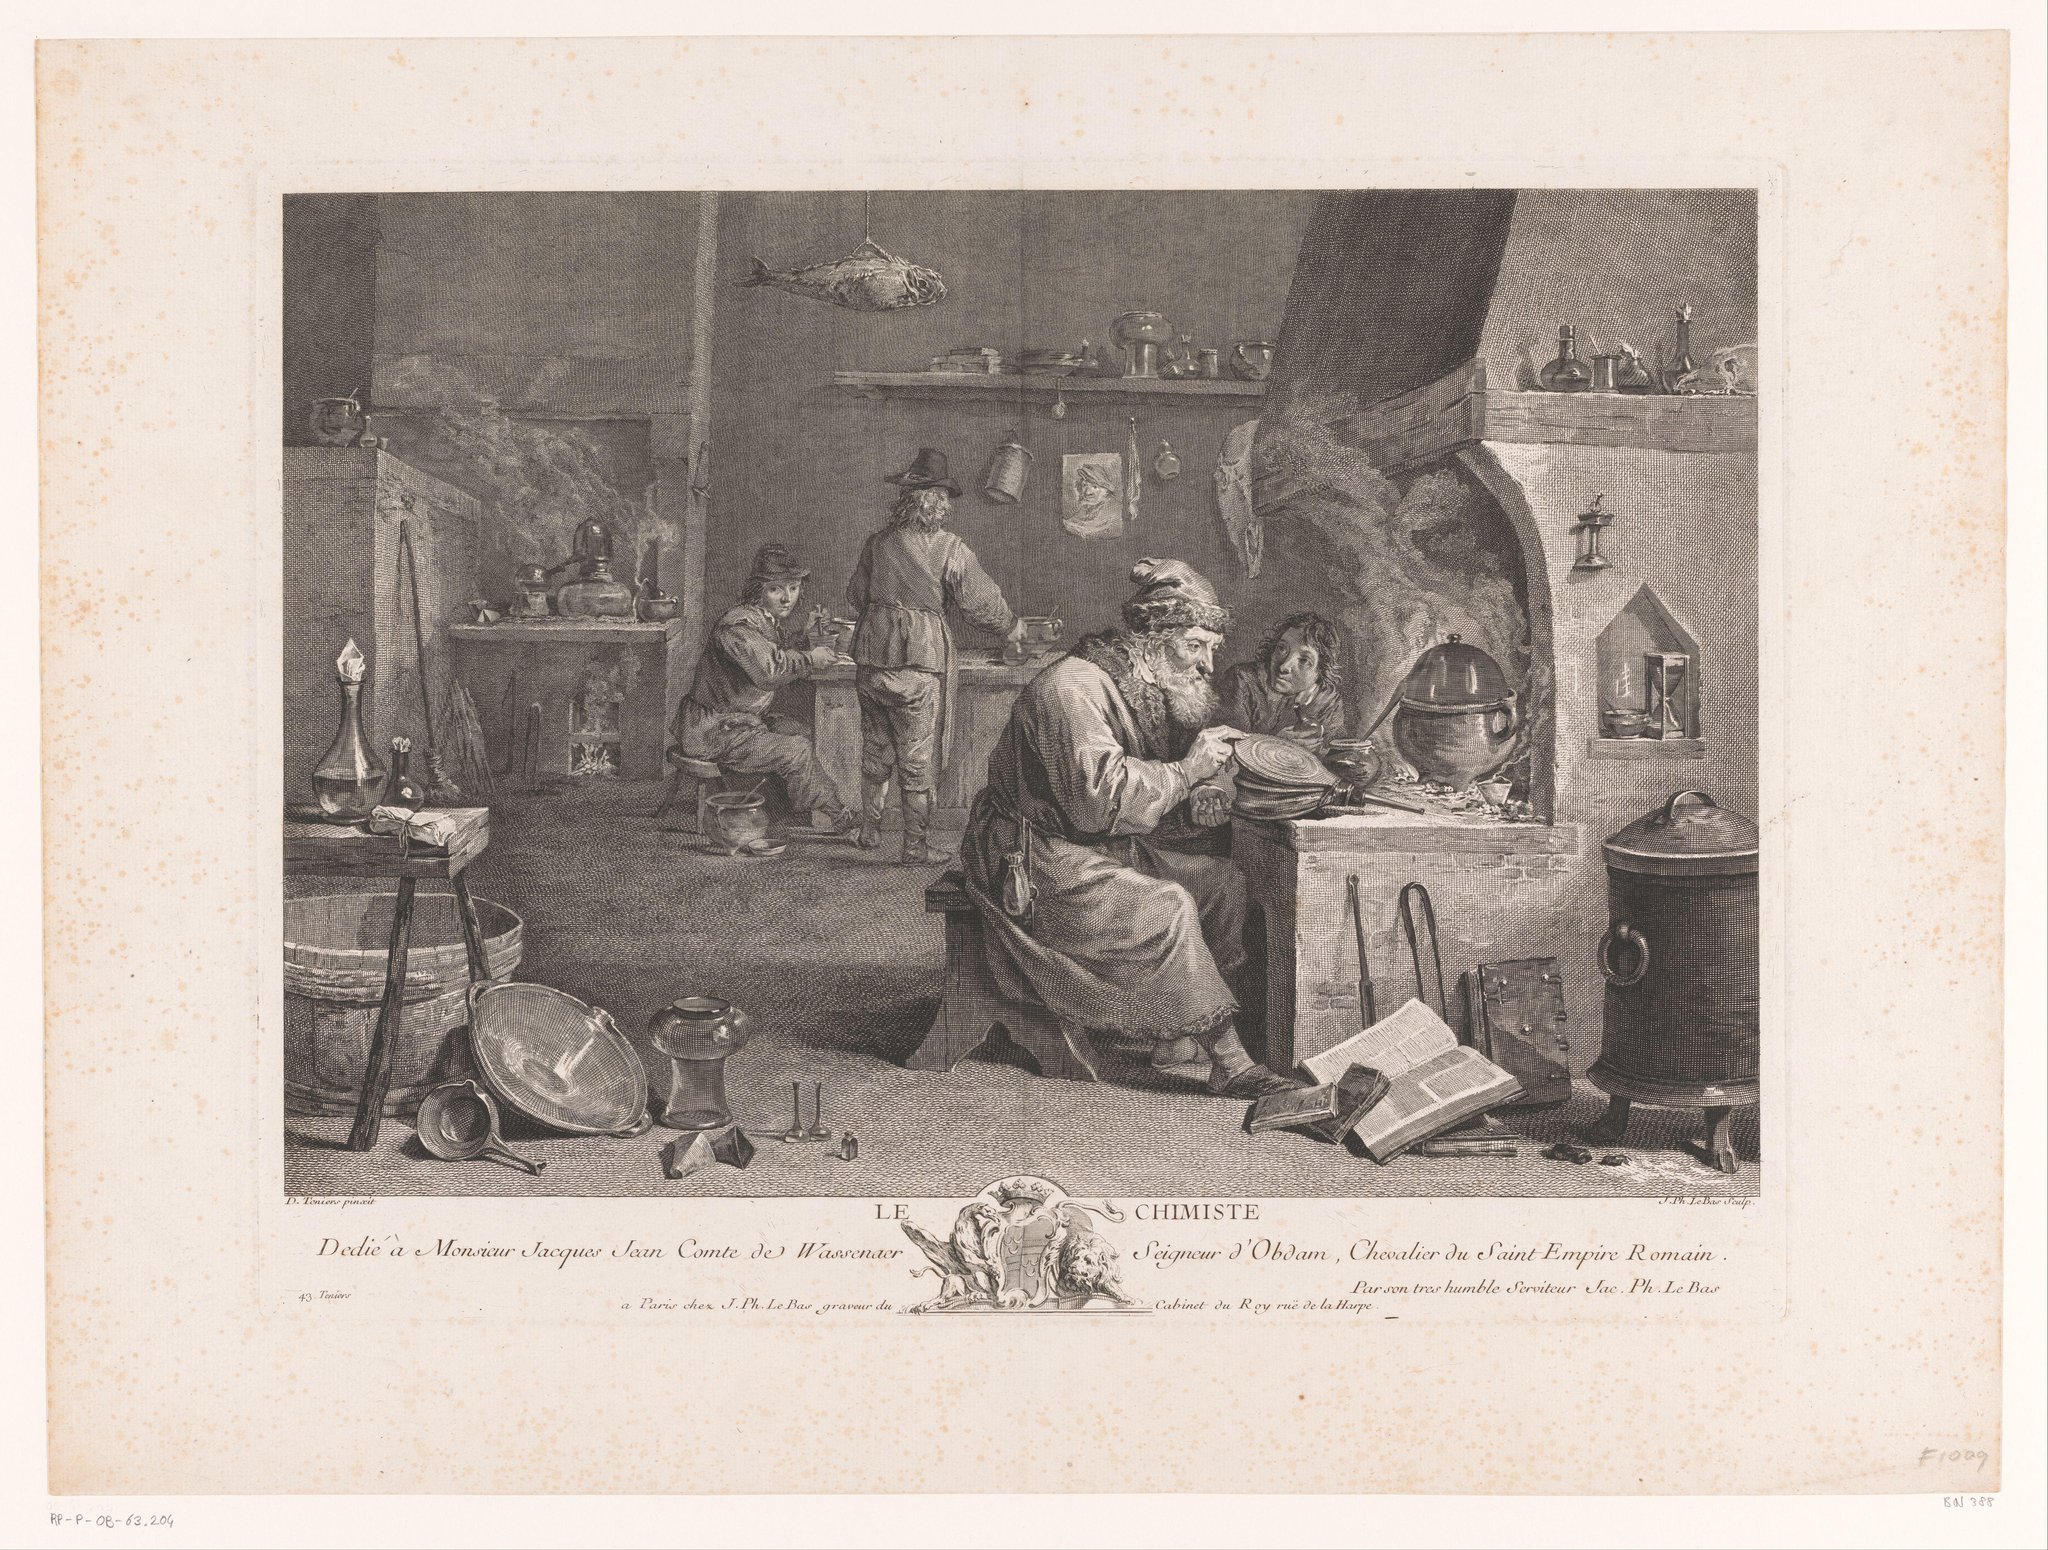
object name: print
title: Alchemist in zijn werkplaats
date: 1747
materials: paper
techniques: engraving, etching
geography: paris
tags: alchemist at work, laboratory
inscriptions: collector's mark: Lugt 240